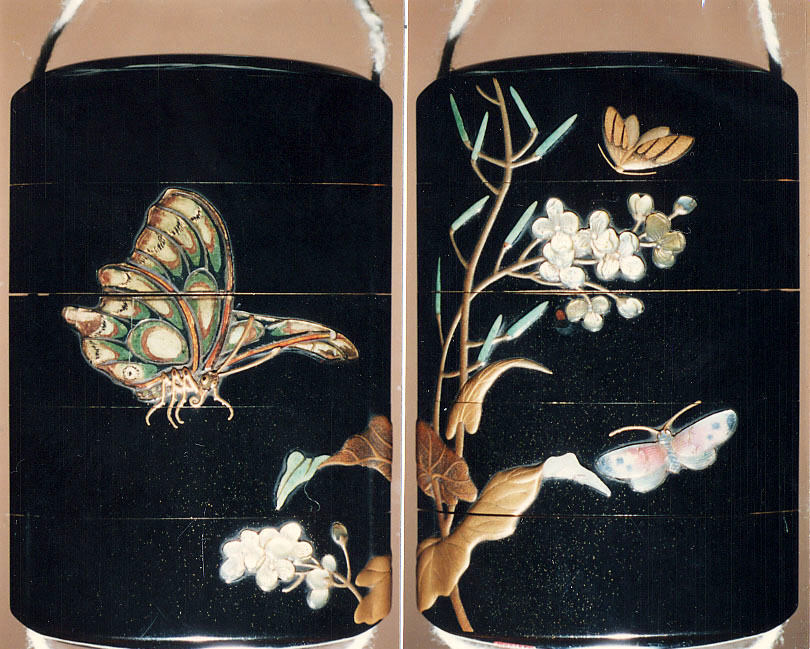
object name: inrō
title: Case (Inrō) with Design of Moth and Butterflies beside Flowering Mustard Plant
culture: japanese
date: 1801-1900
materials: ceramic, gold, lacquer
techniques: fundame, inlay, roiro, maki-e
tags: butterflies,flowers